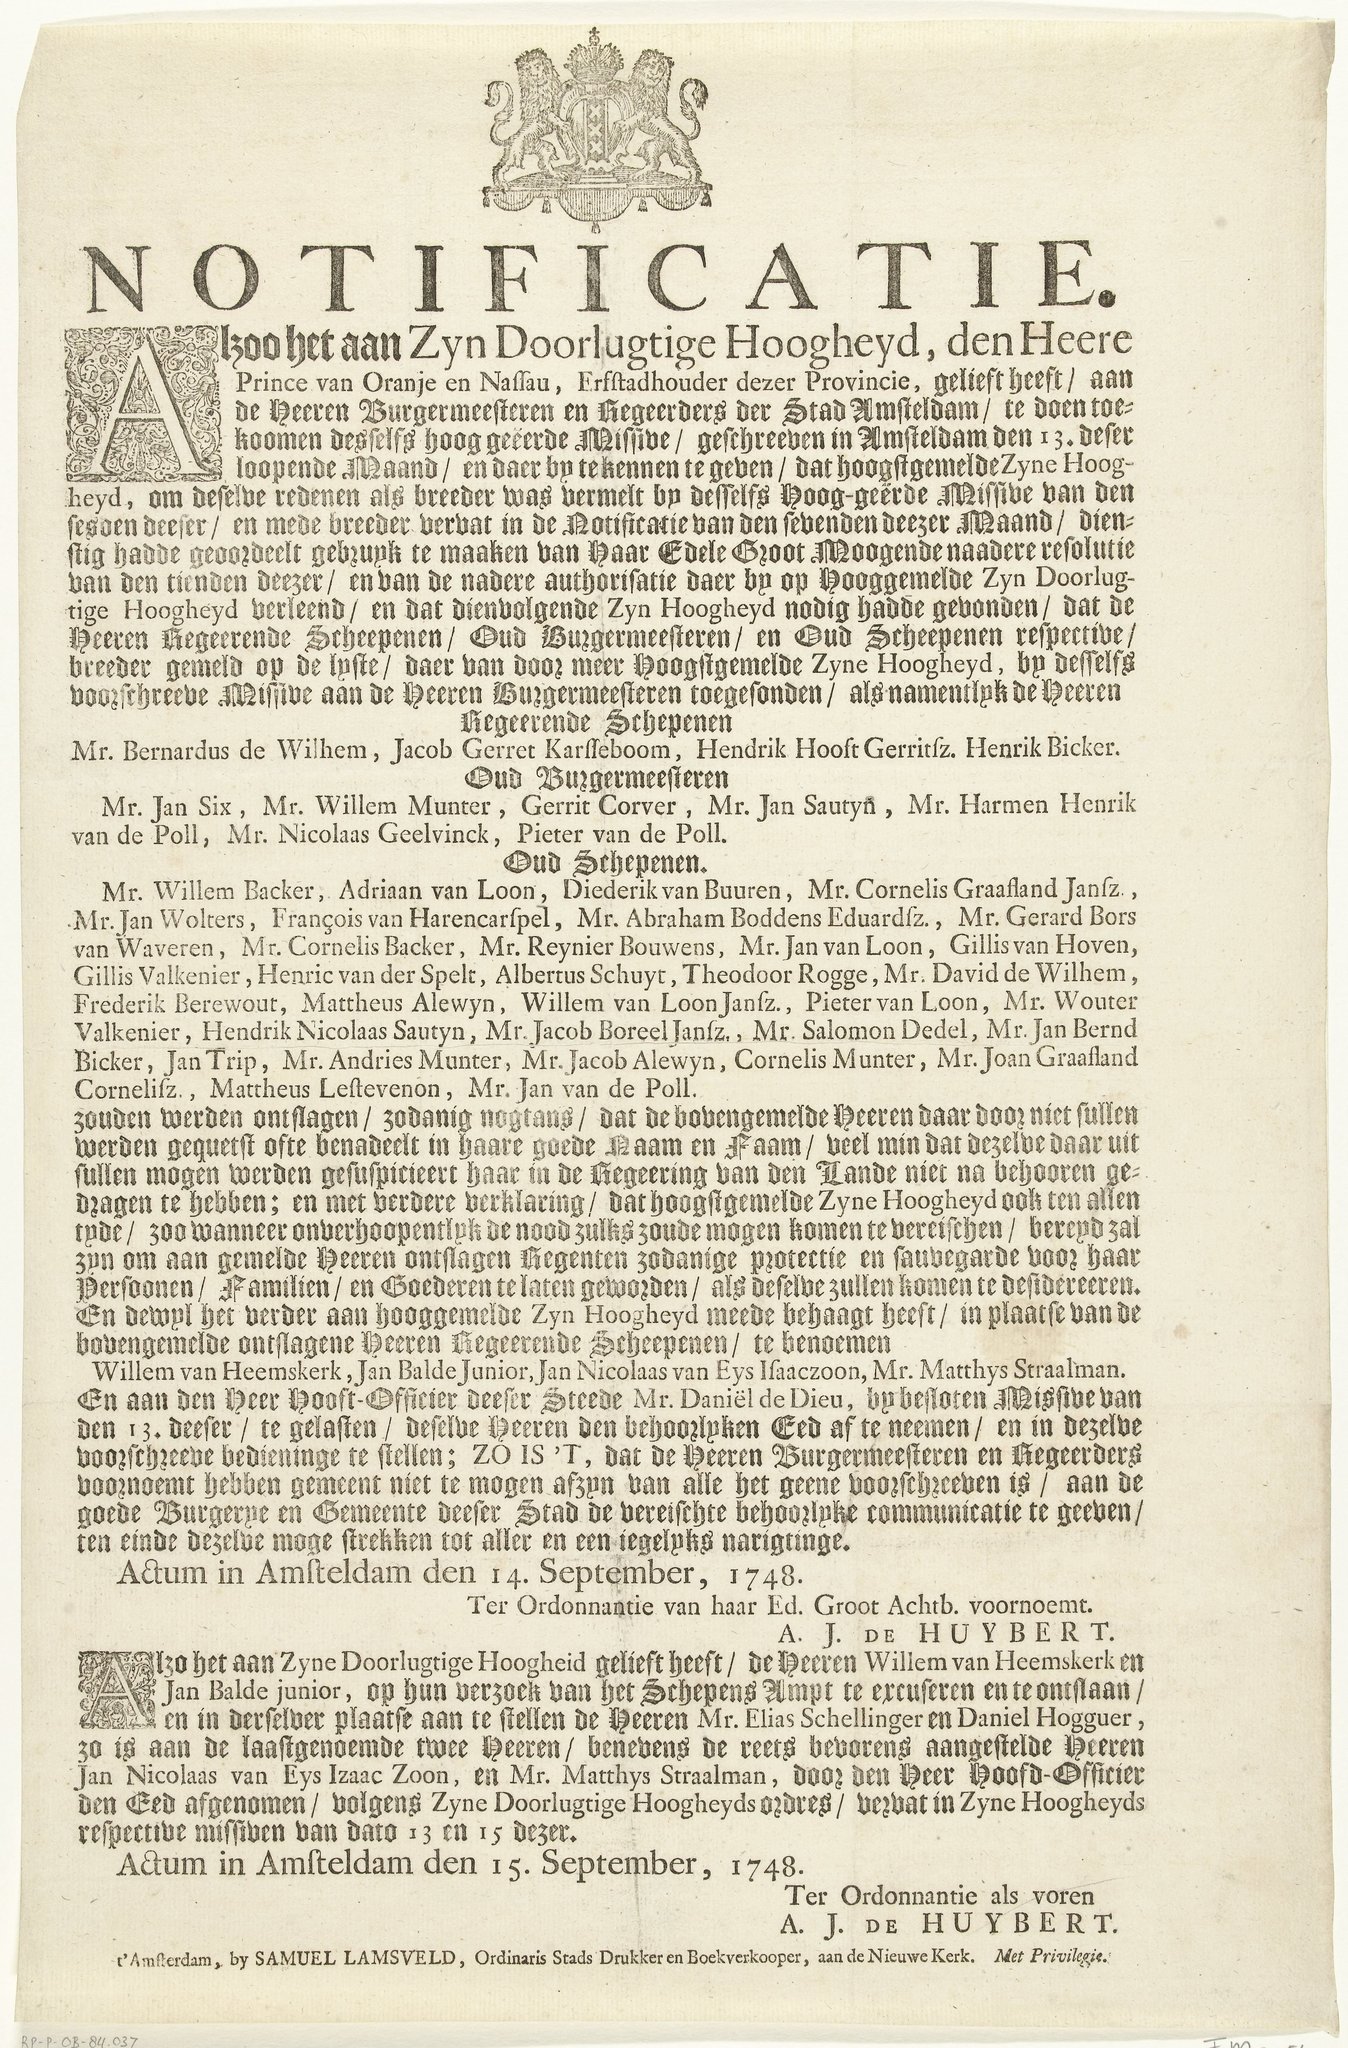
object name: text sheet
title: Notificatie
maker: samuel lamsveld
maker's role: bookseller, printer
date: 1748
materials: paper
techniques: letterpress printing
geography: amsterdam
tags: willem iv (prins van oranje-nassau), amsterdam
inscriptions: collector's mark: Lugt 2228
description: Tekstblad met de bekendmaking namens de prins van de verwijdering van meerdere leden van het stadsbestuur van Amsterdam, 13-15 september 1748. Boven de tekst het wapen van Amsterdam.